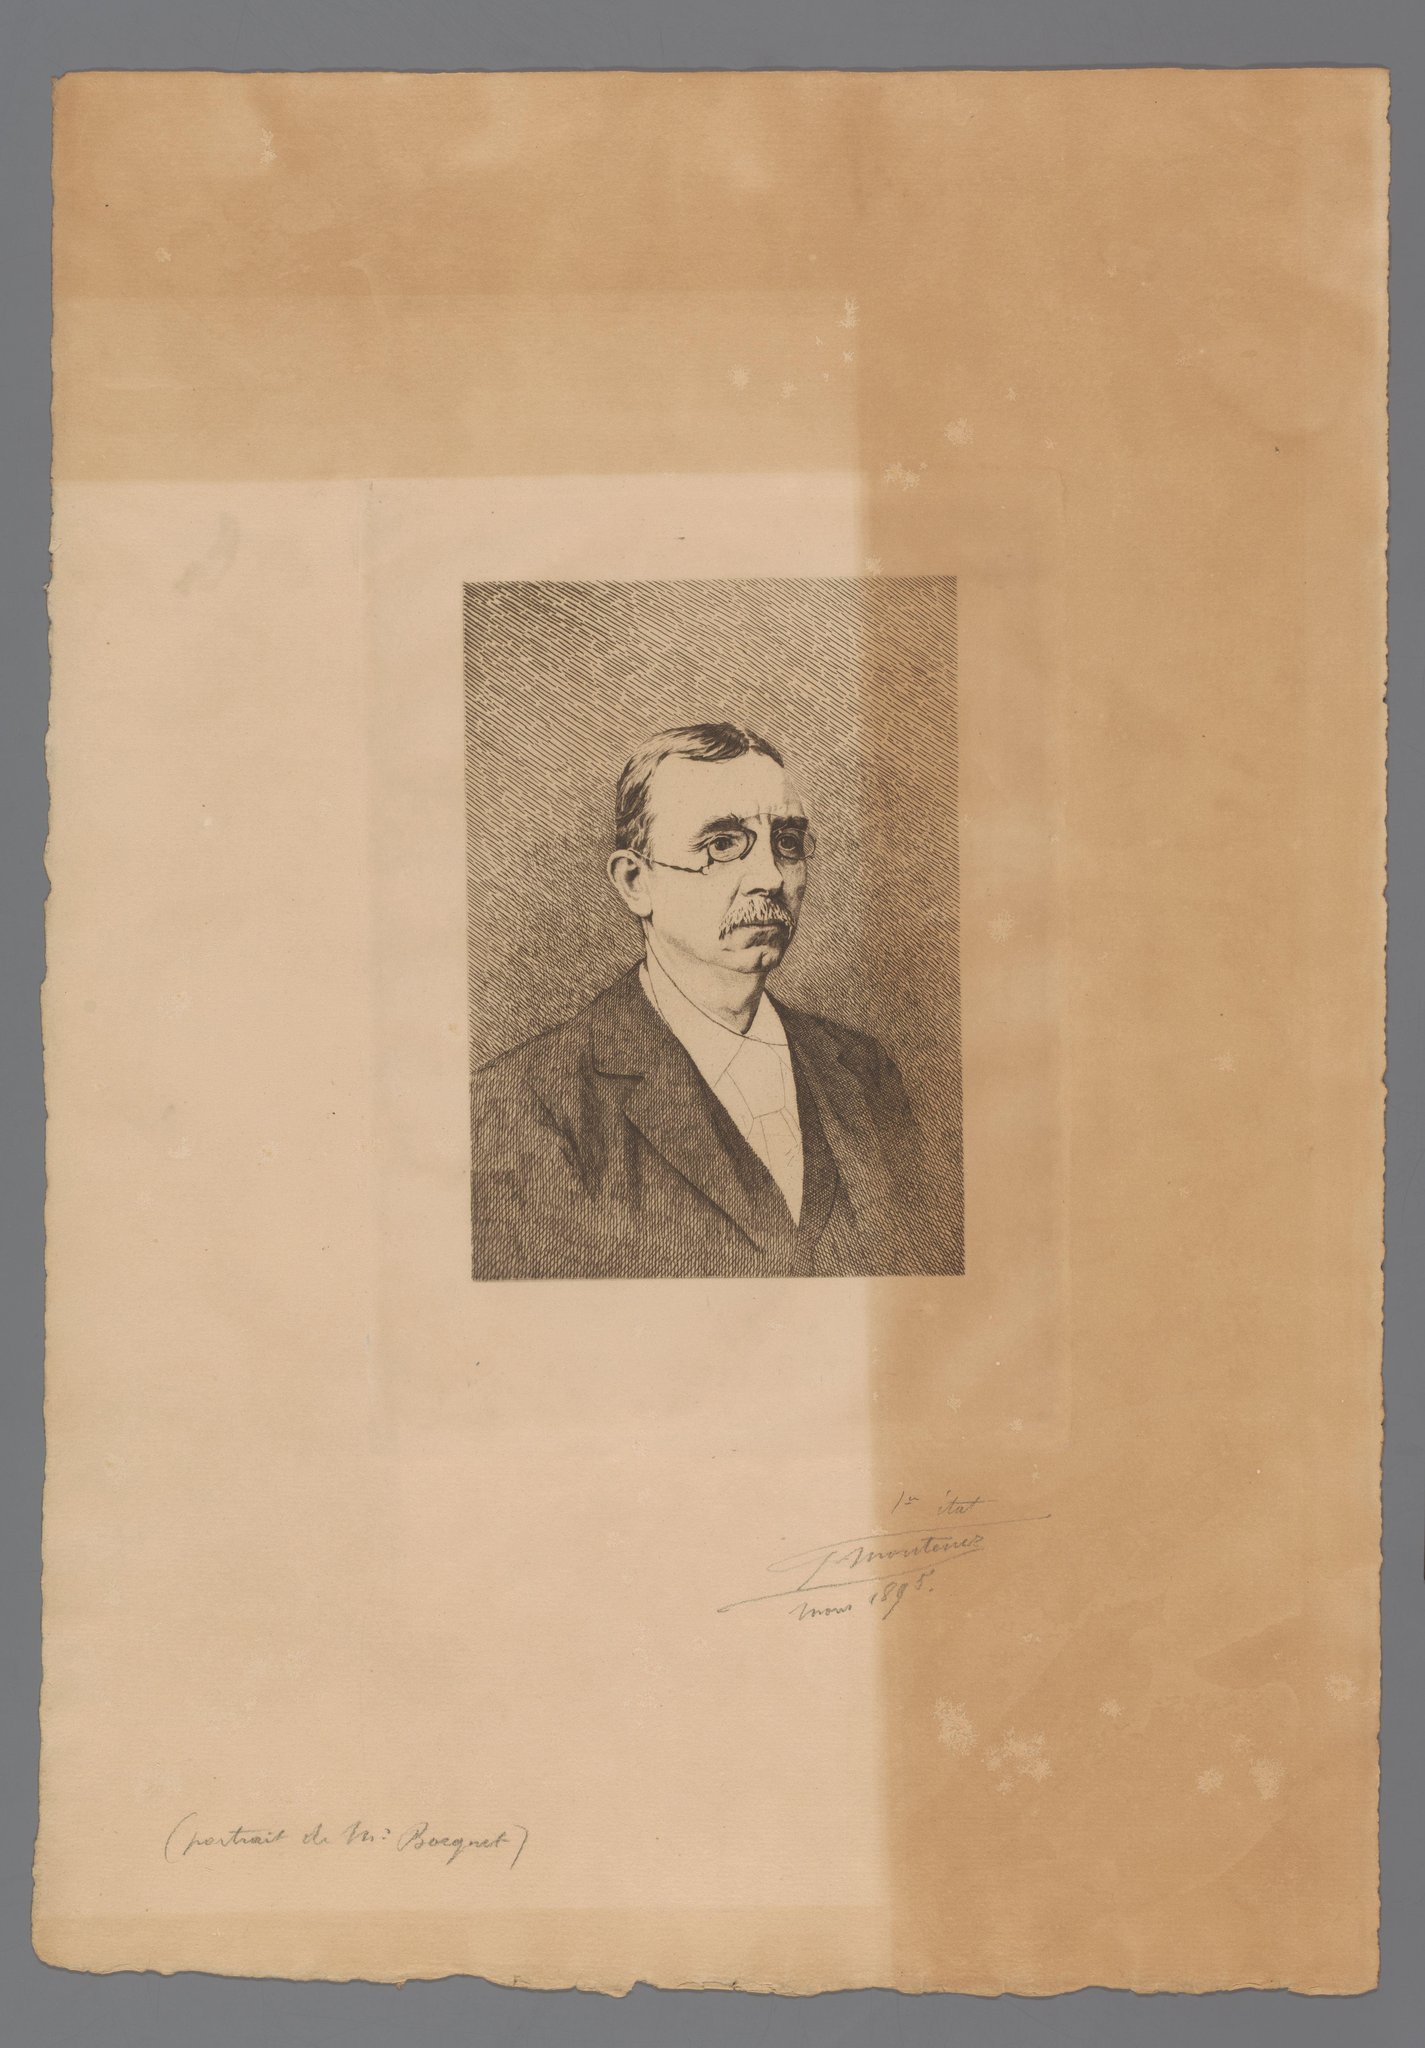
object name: print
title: Portret van een onbekende man, mogelijk Bocquet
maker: georges montenez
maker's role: print maker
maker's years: 1873-1930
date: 1895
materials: paper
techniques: etching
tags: eyeglasses, spectacles, moustache, adult man, historical persons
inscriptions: collector's mark: Lugt 2228, inscription: ‘1e état; Mons 1895’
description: In de inventaris getiteld: Portret van Mr. Bocquet.